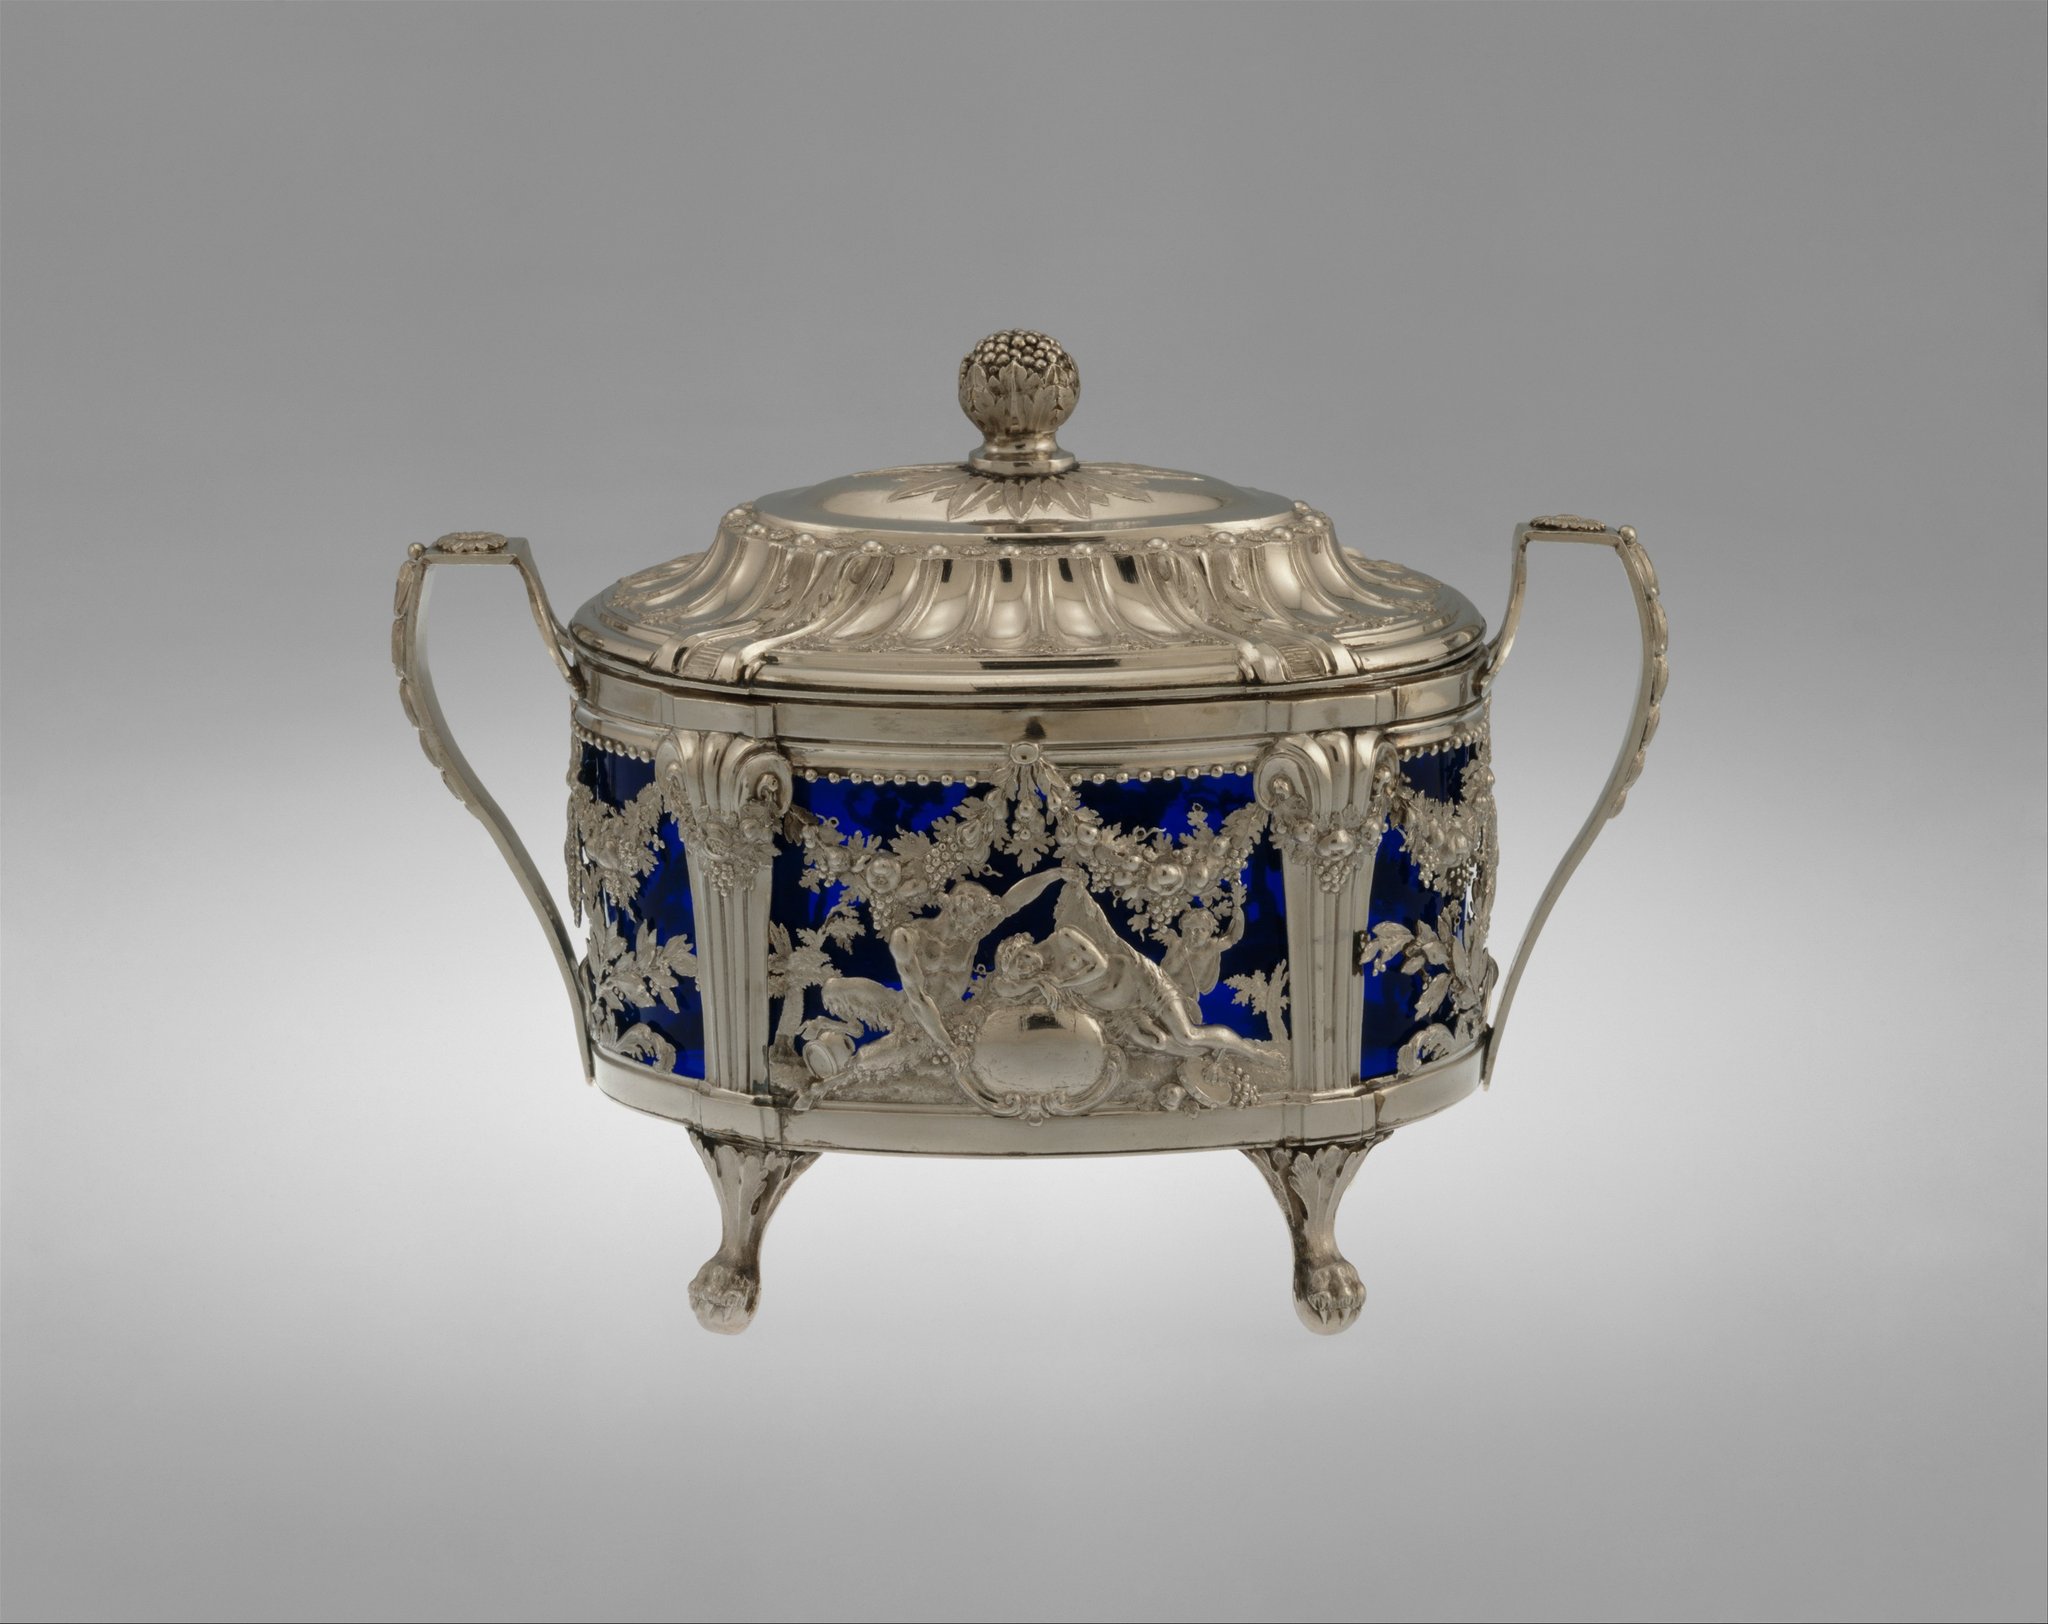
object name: sugar bowl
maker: marc-etienne janety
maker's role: maker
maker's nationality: french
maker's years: 1739-1820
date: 1786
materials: glass, platinum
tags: grapes,nymphs,satyrs